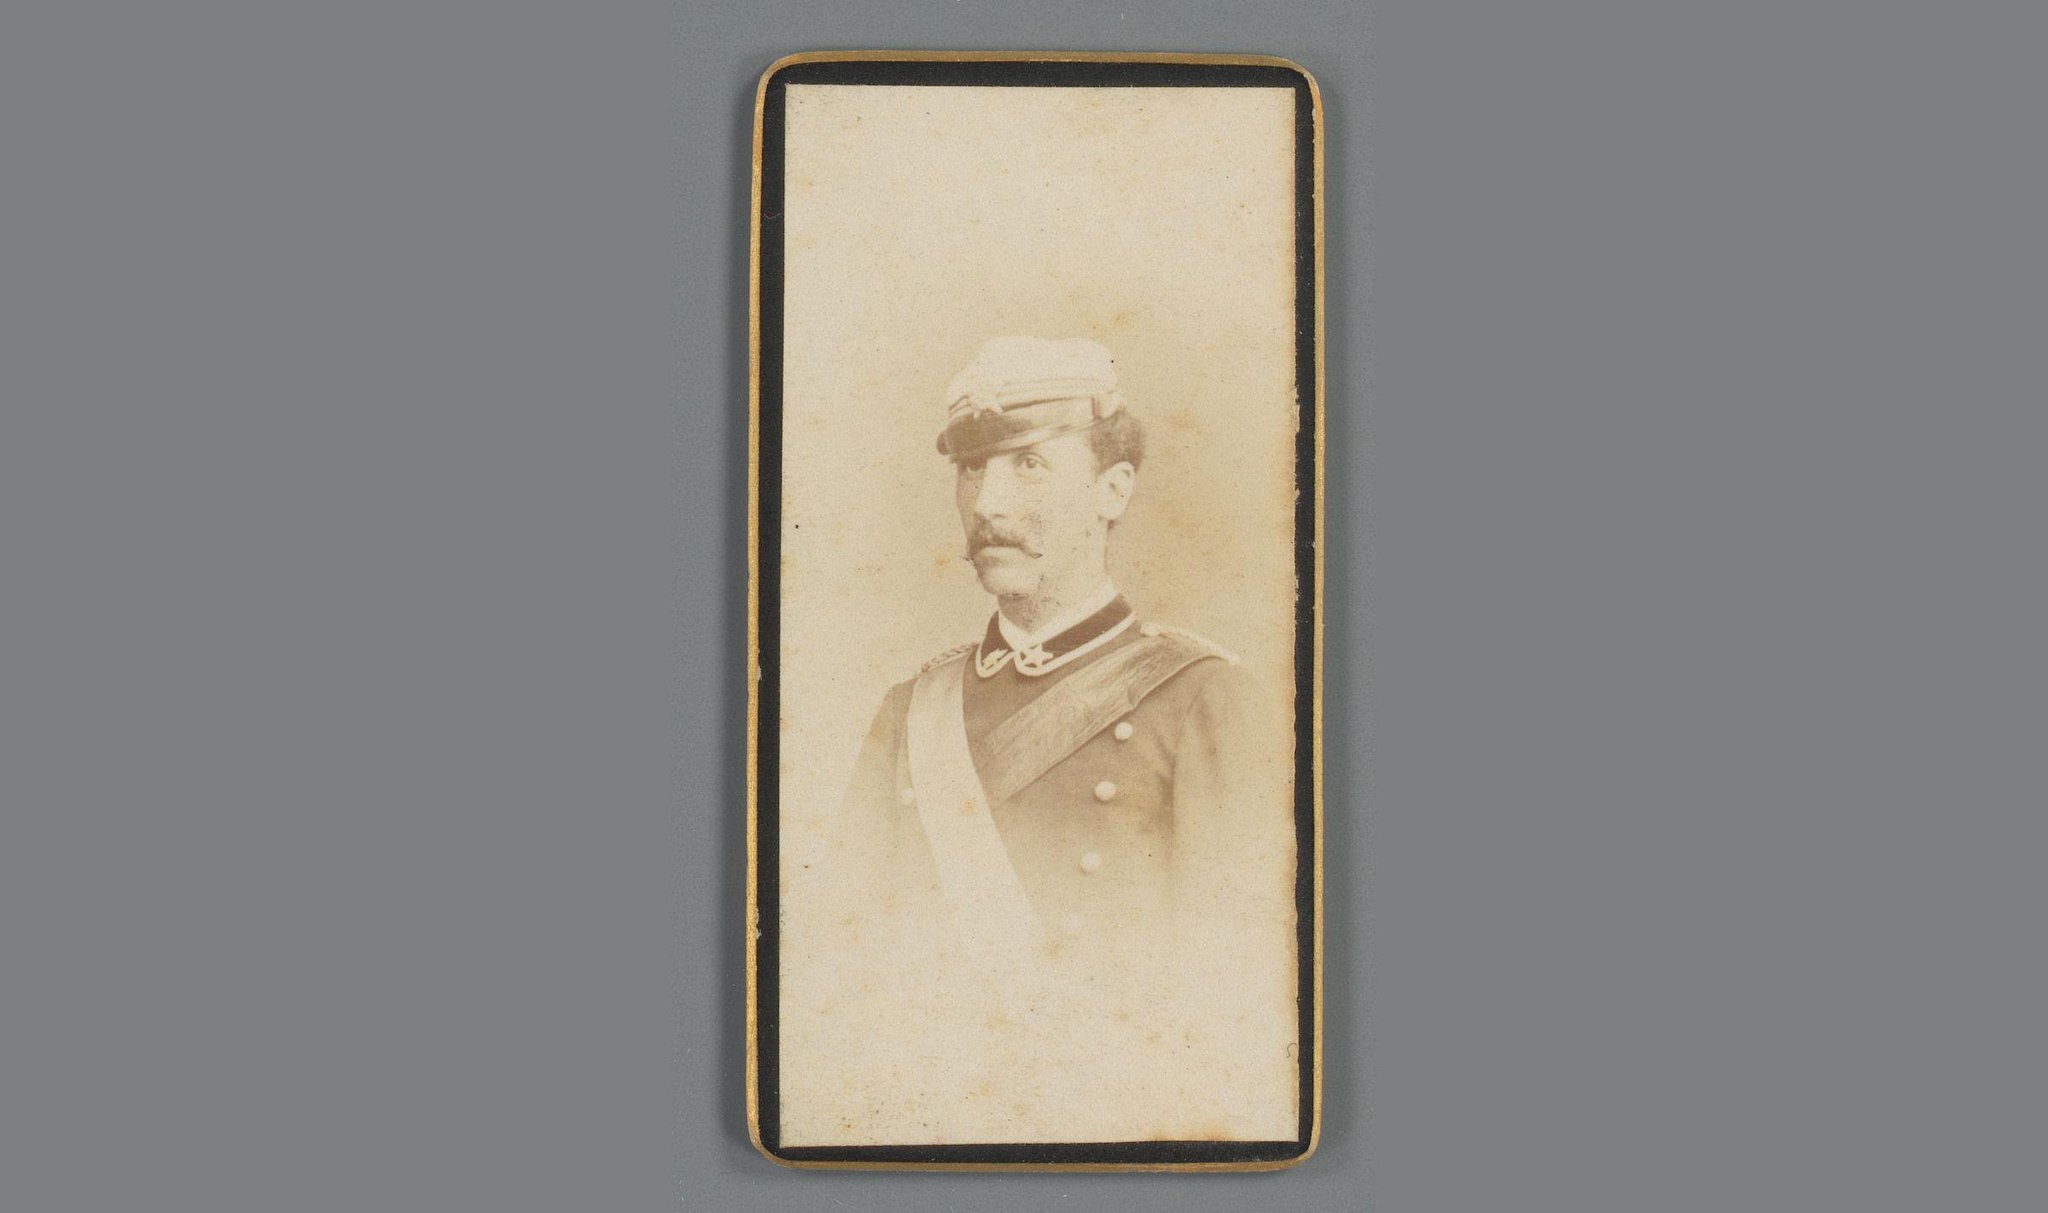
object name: photograph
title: Miniatuurportret van een onbekende man in uniform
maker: Anonymous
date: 1880-1910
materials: cardboard, paper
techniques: albumen print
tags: adult man, anonymous historical person portrayed, (military) uniforms